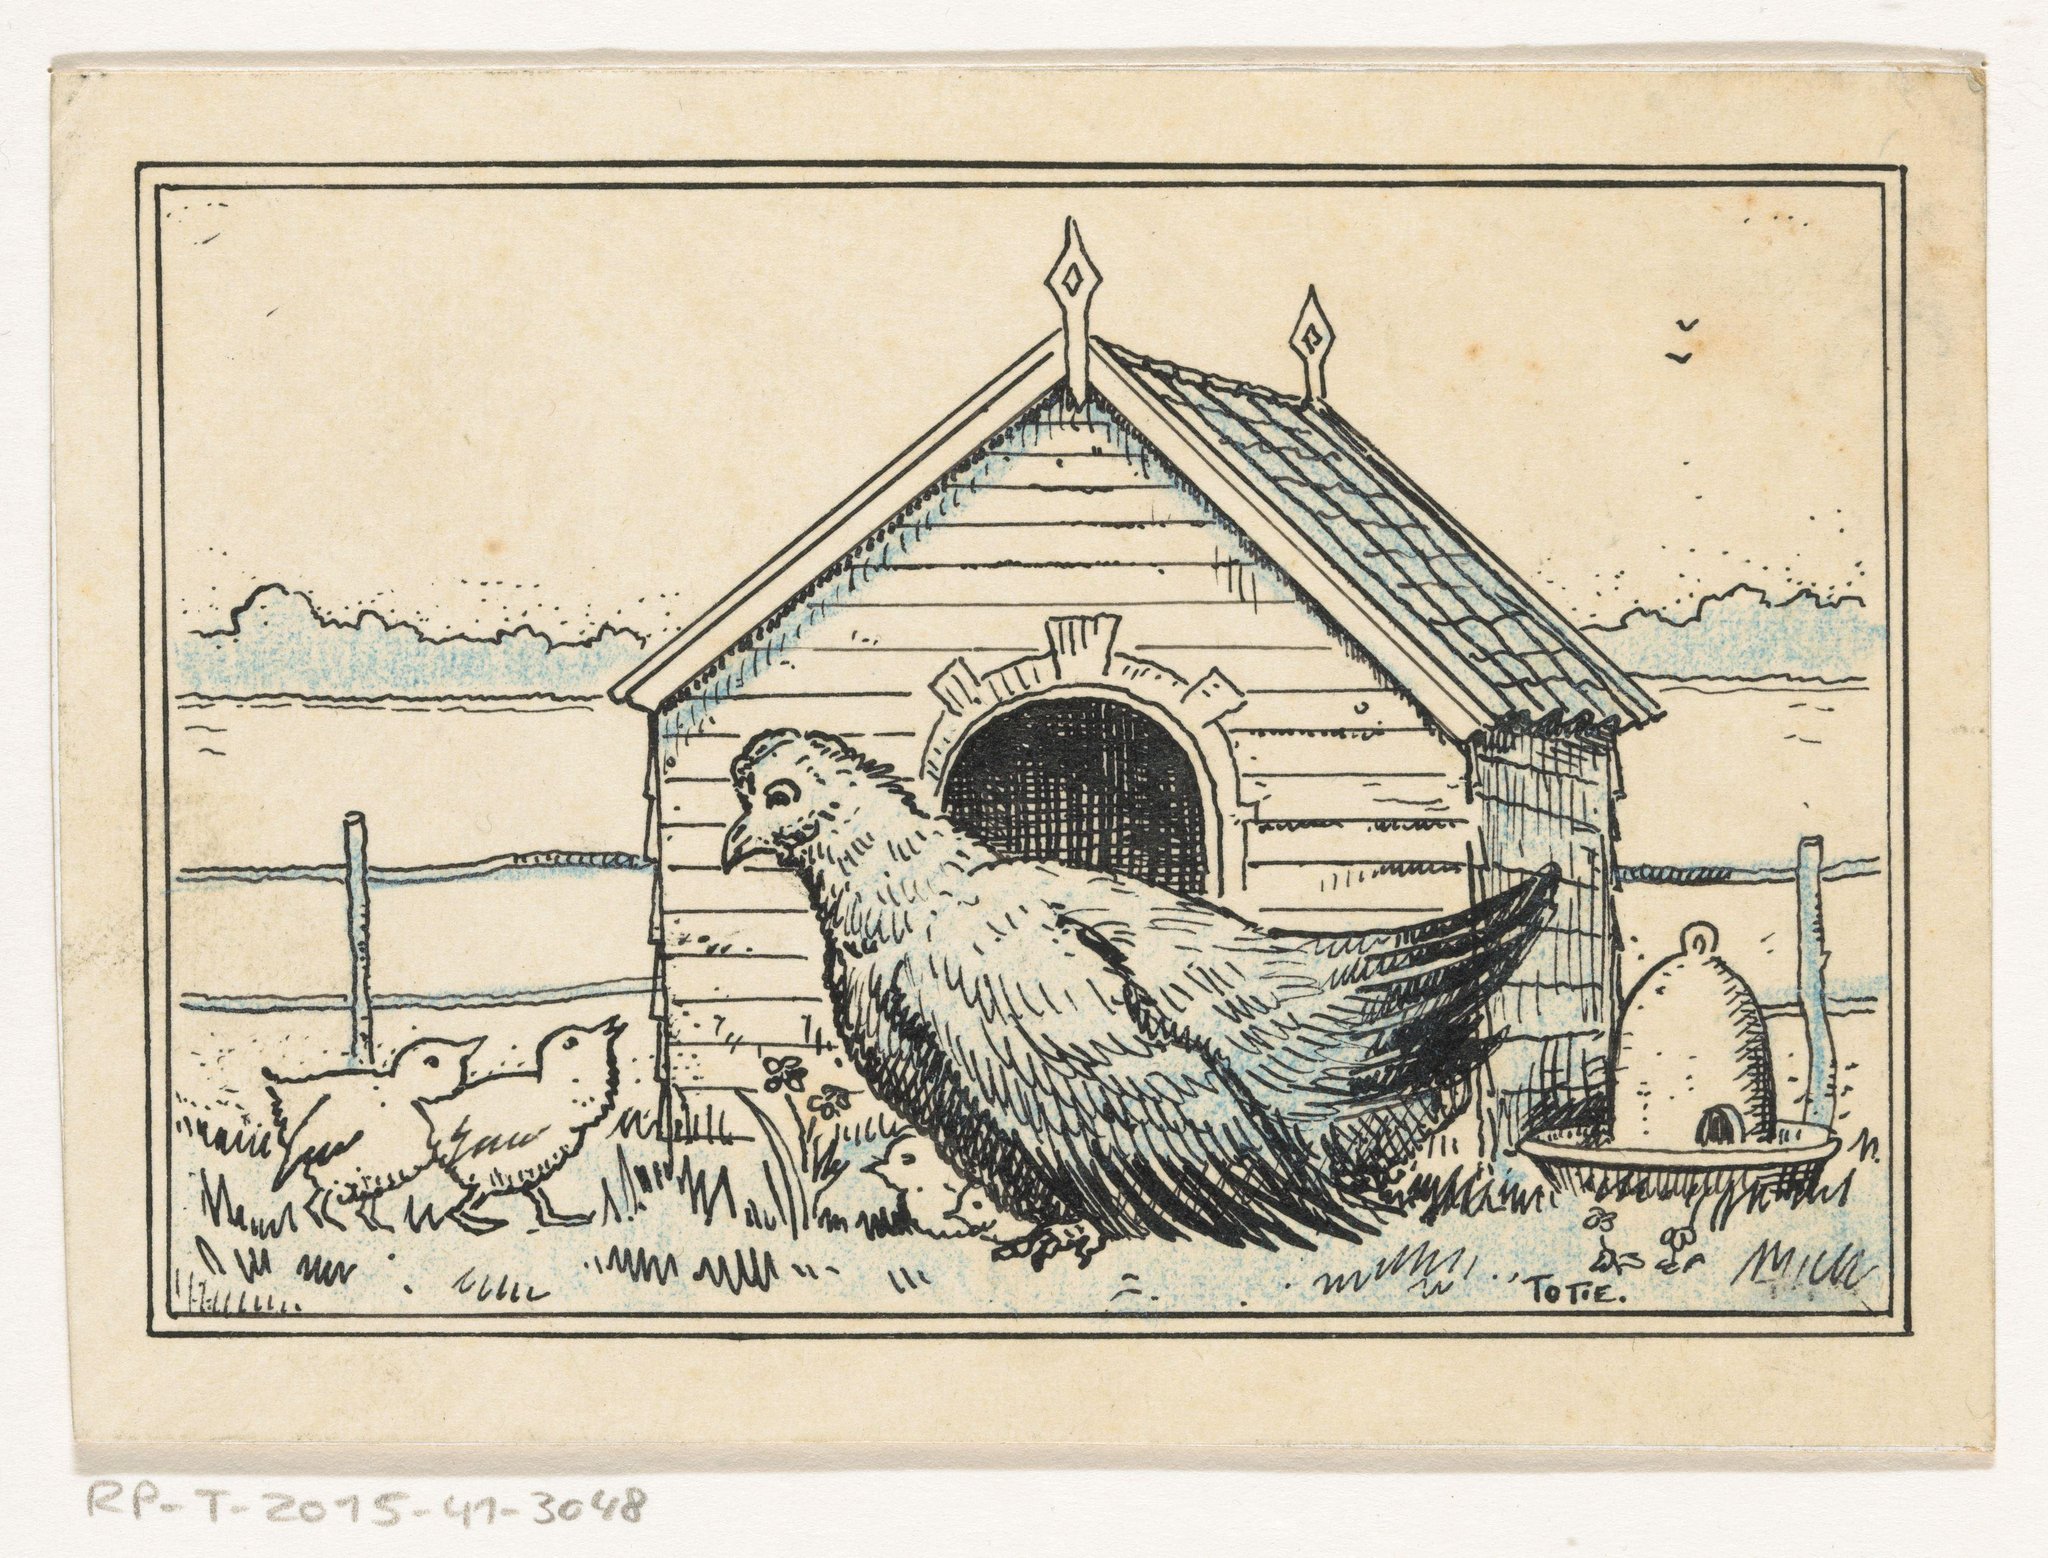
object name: drawing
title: Kip en kuikens voor een kippenhuis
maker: totie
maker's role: draughtsman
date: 1890-1930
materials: cardboard, ink, pencil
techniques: pen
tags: fowl (cock, hen, chicken, etc.), chicken house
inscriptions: :, collector's mark: Lugt 2228a, signature: ‘TOTIE.’